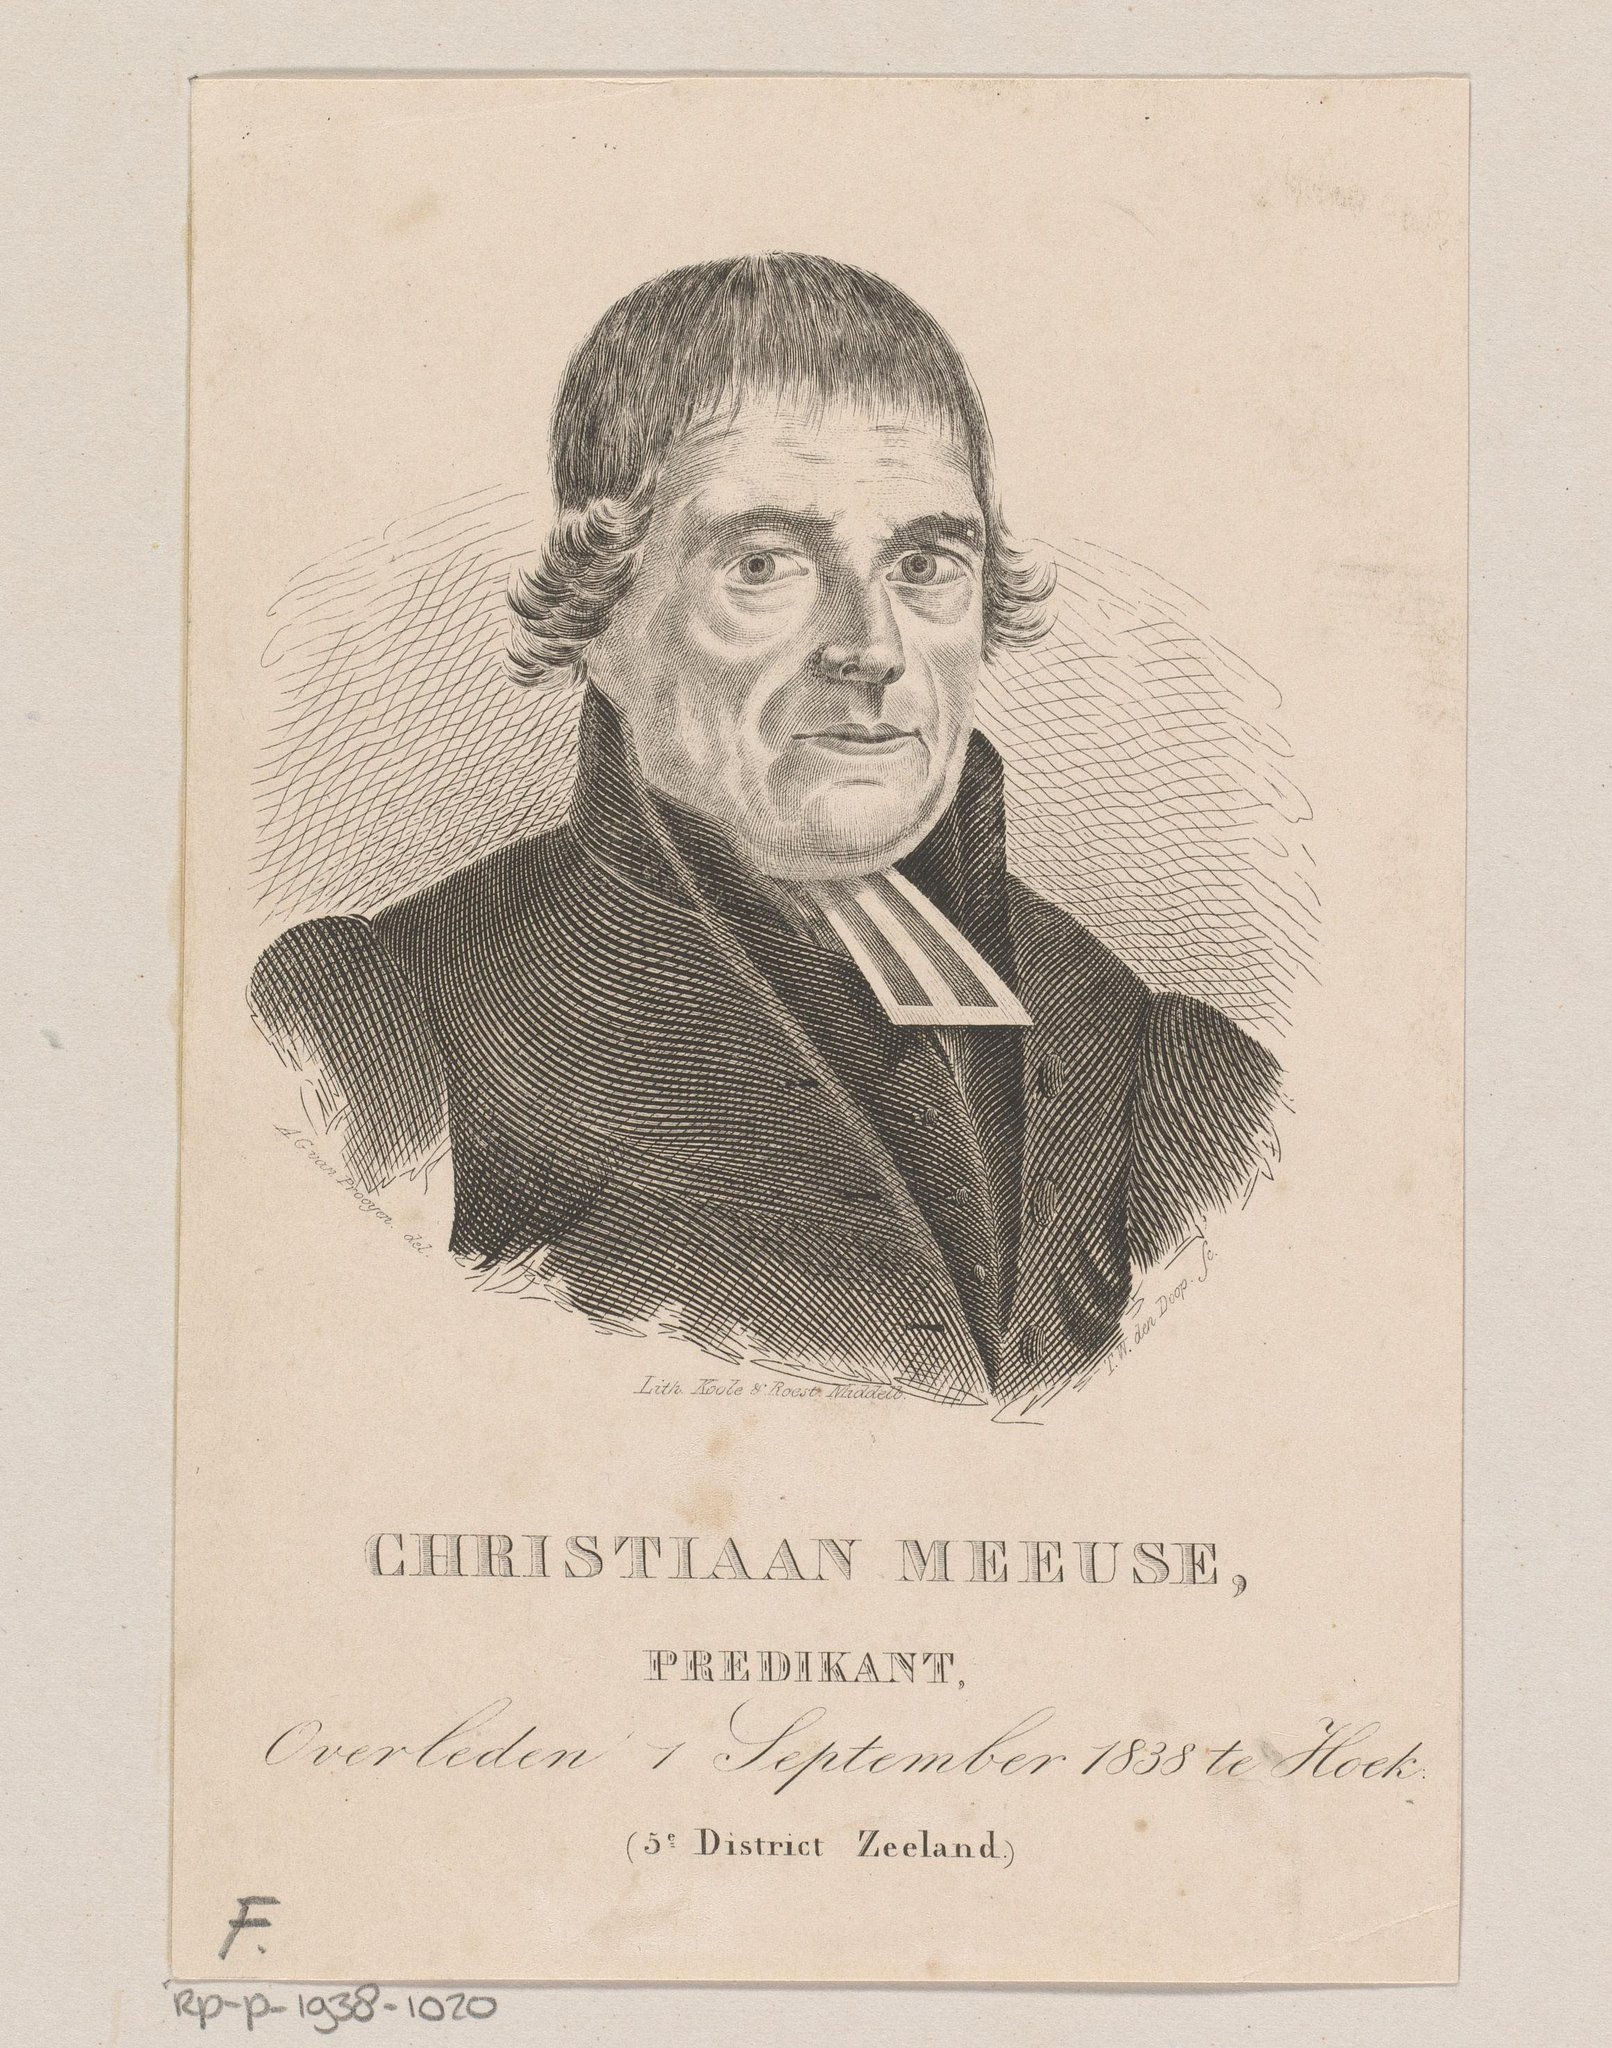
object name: print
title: Christiaan Meeuse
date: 1838-1880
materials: paper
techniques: lithograph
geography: middelburg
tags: historical persons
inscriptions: collector's mark: Lugt 2228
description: Met drieregelig onderschrift in het Nederlands.